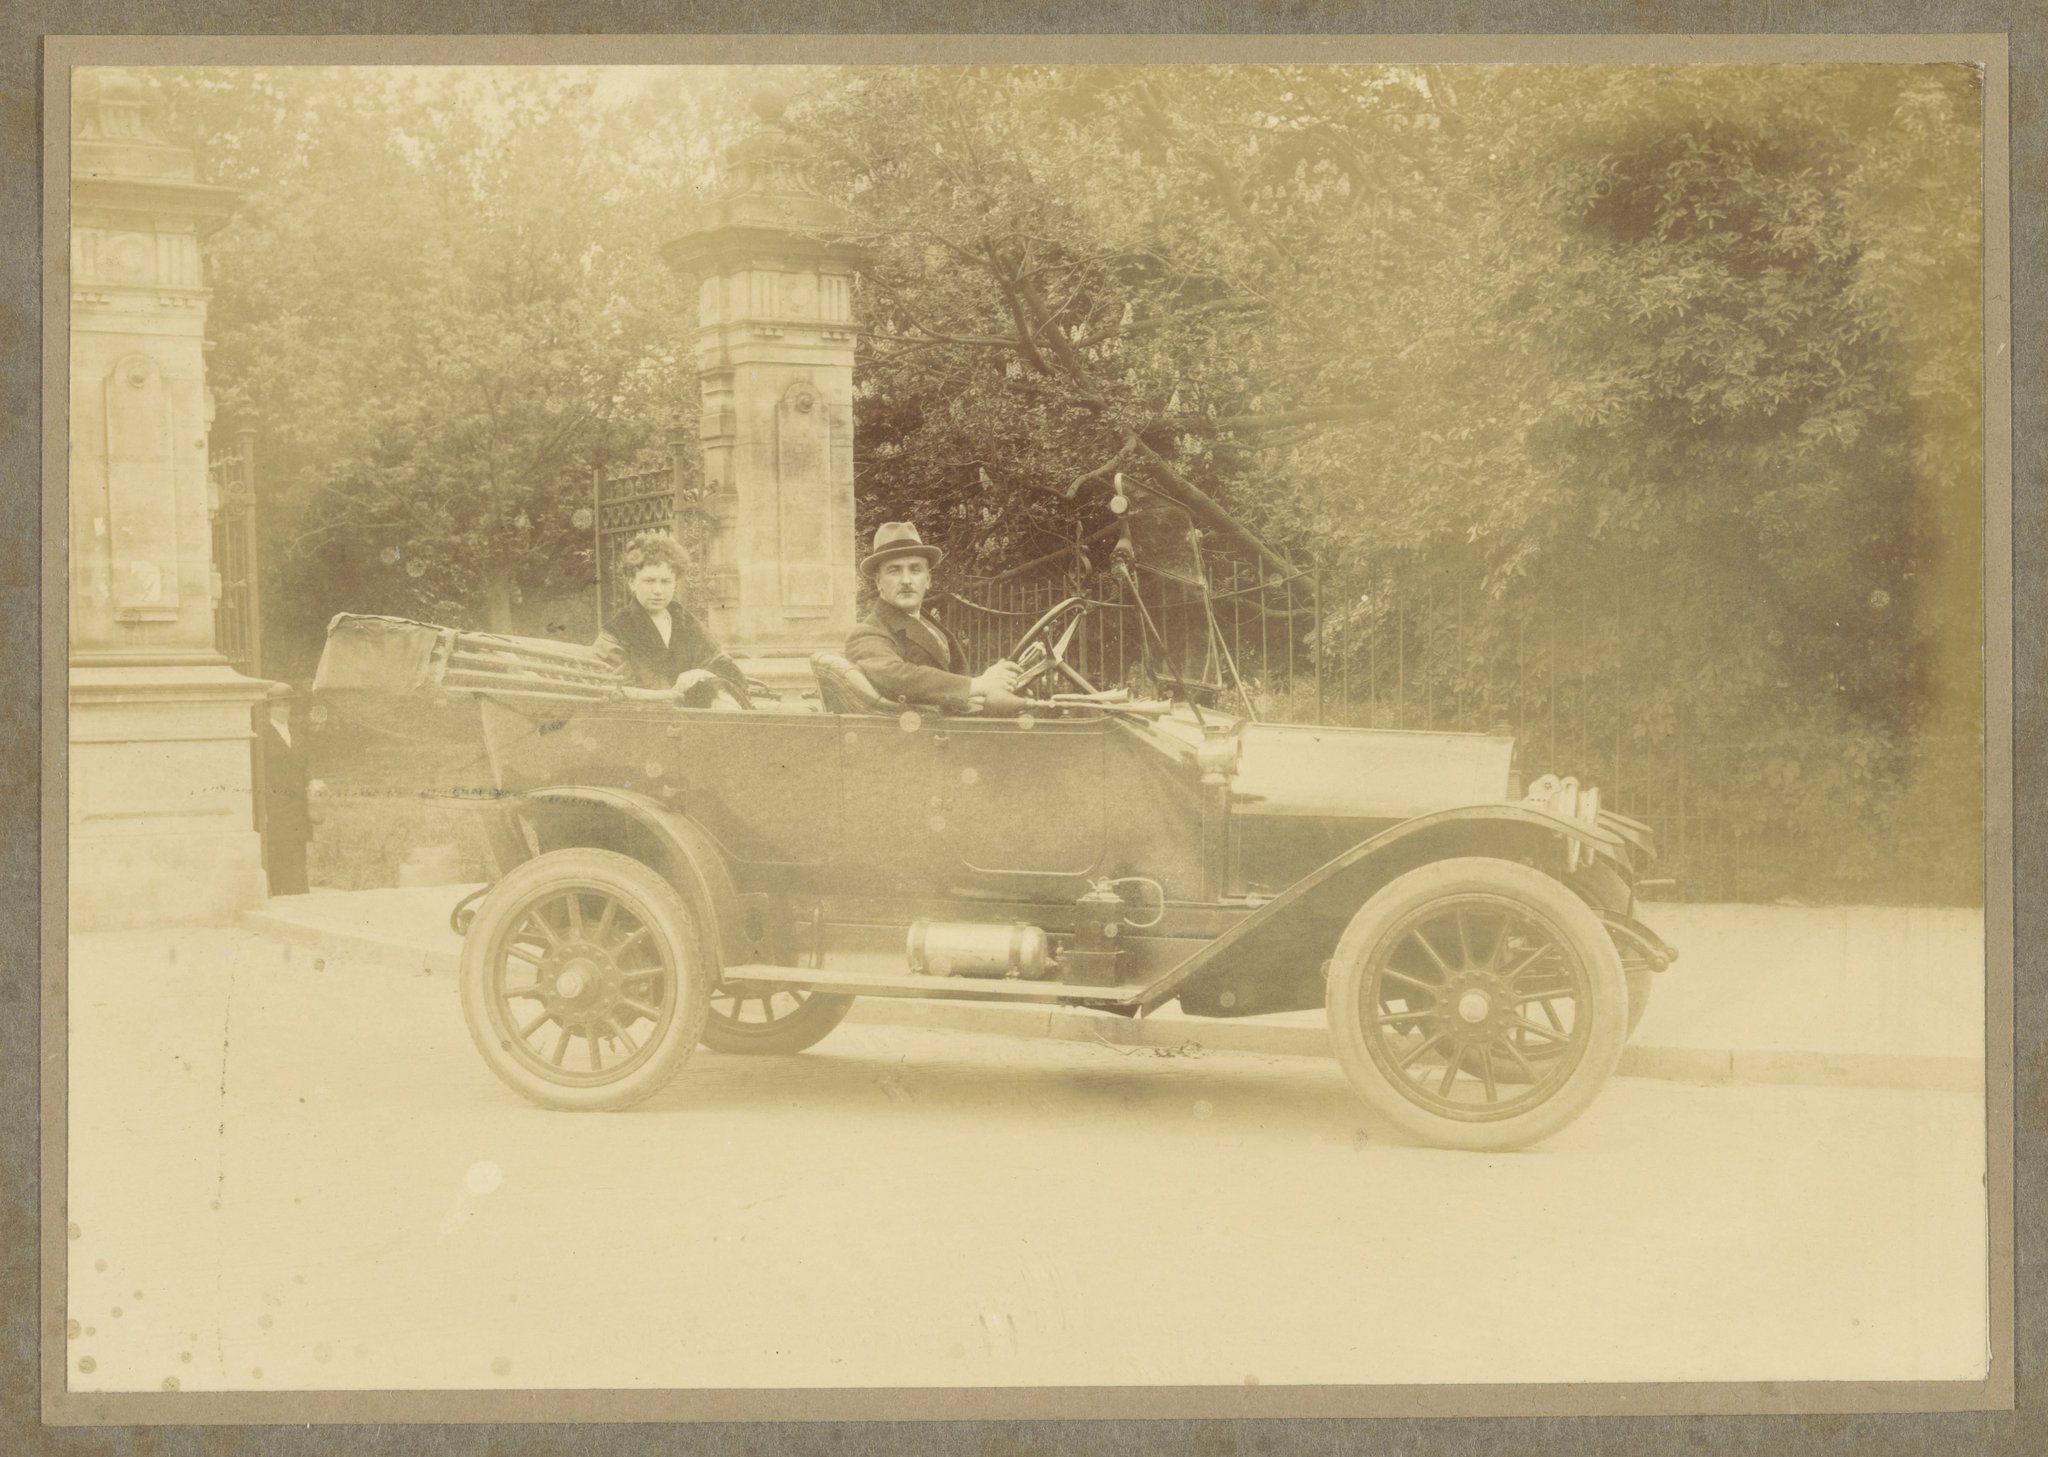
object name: photograph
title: Man en vrouw in een auto bij een toegangshek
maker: Anonymous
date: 1905-1915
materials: paper, cardboard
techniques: gelatin silver print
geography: netherlands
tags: automobile